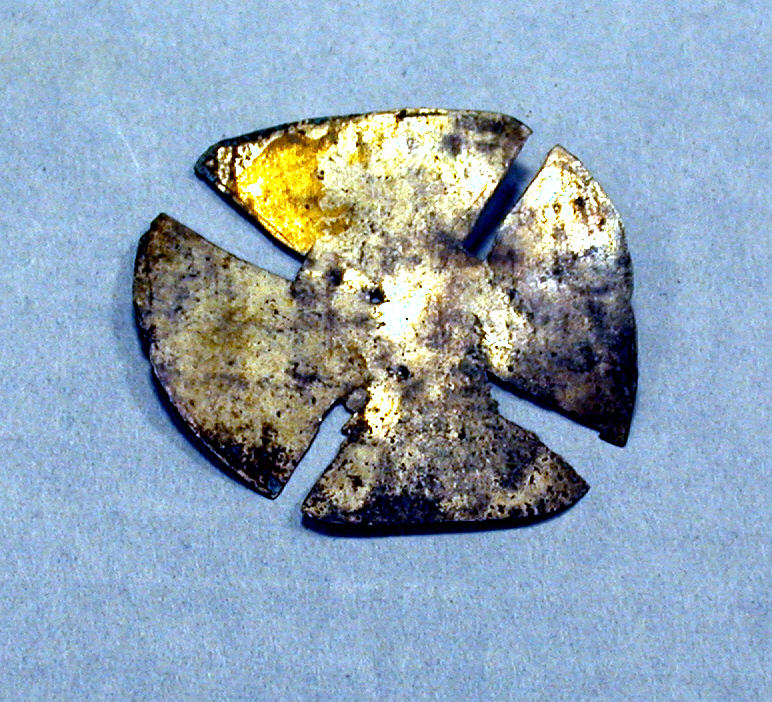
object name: costume ornament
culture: peruvian, north or central coast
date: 701-1566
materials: gilt, silver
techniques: hammering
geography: peru